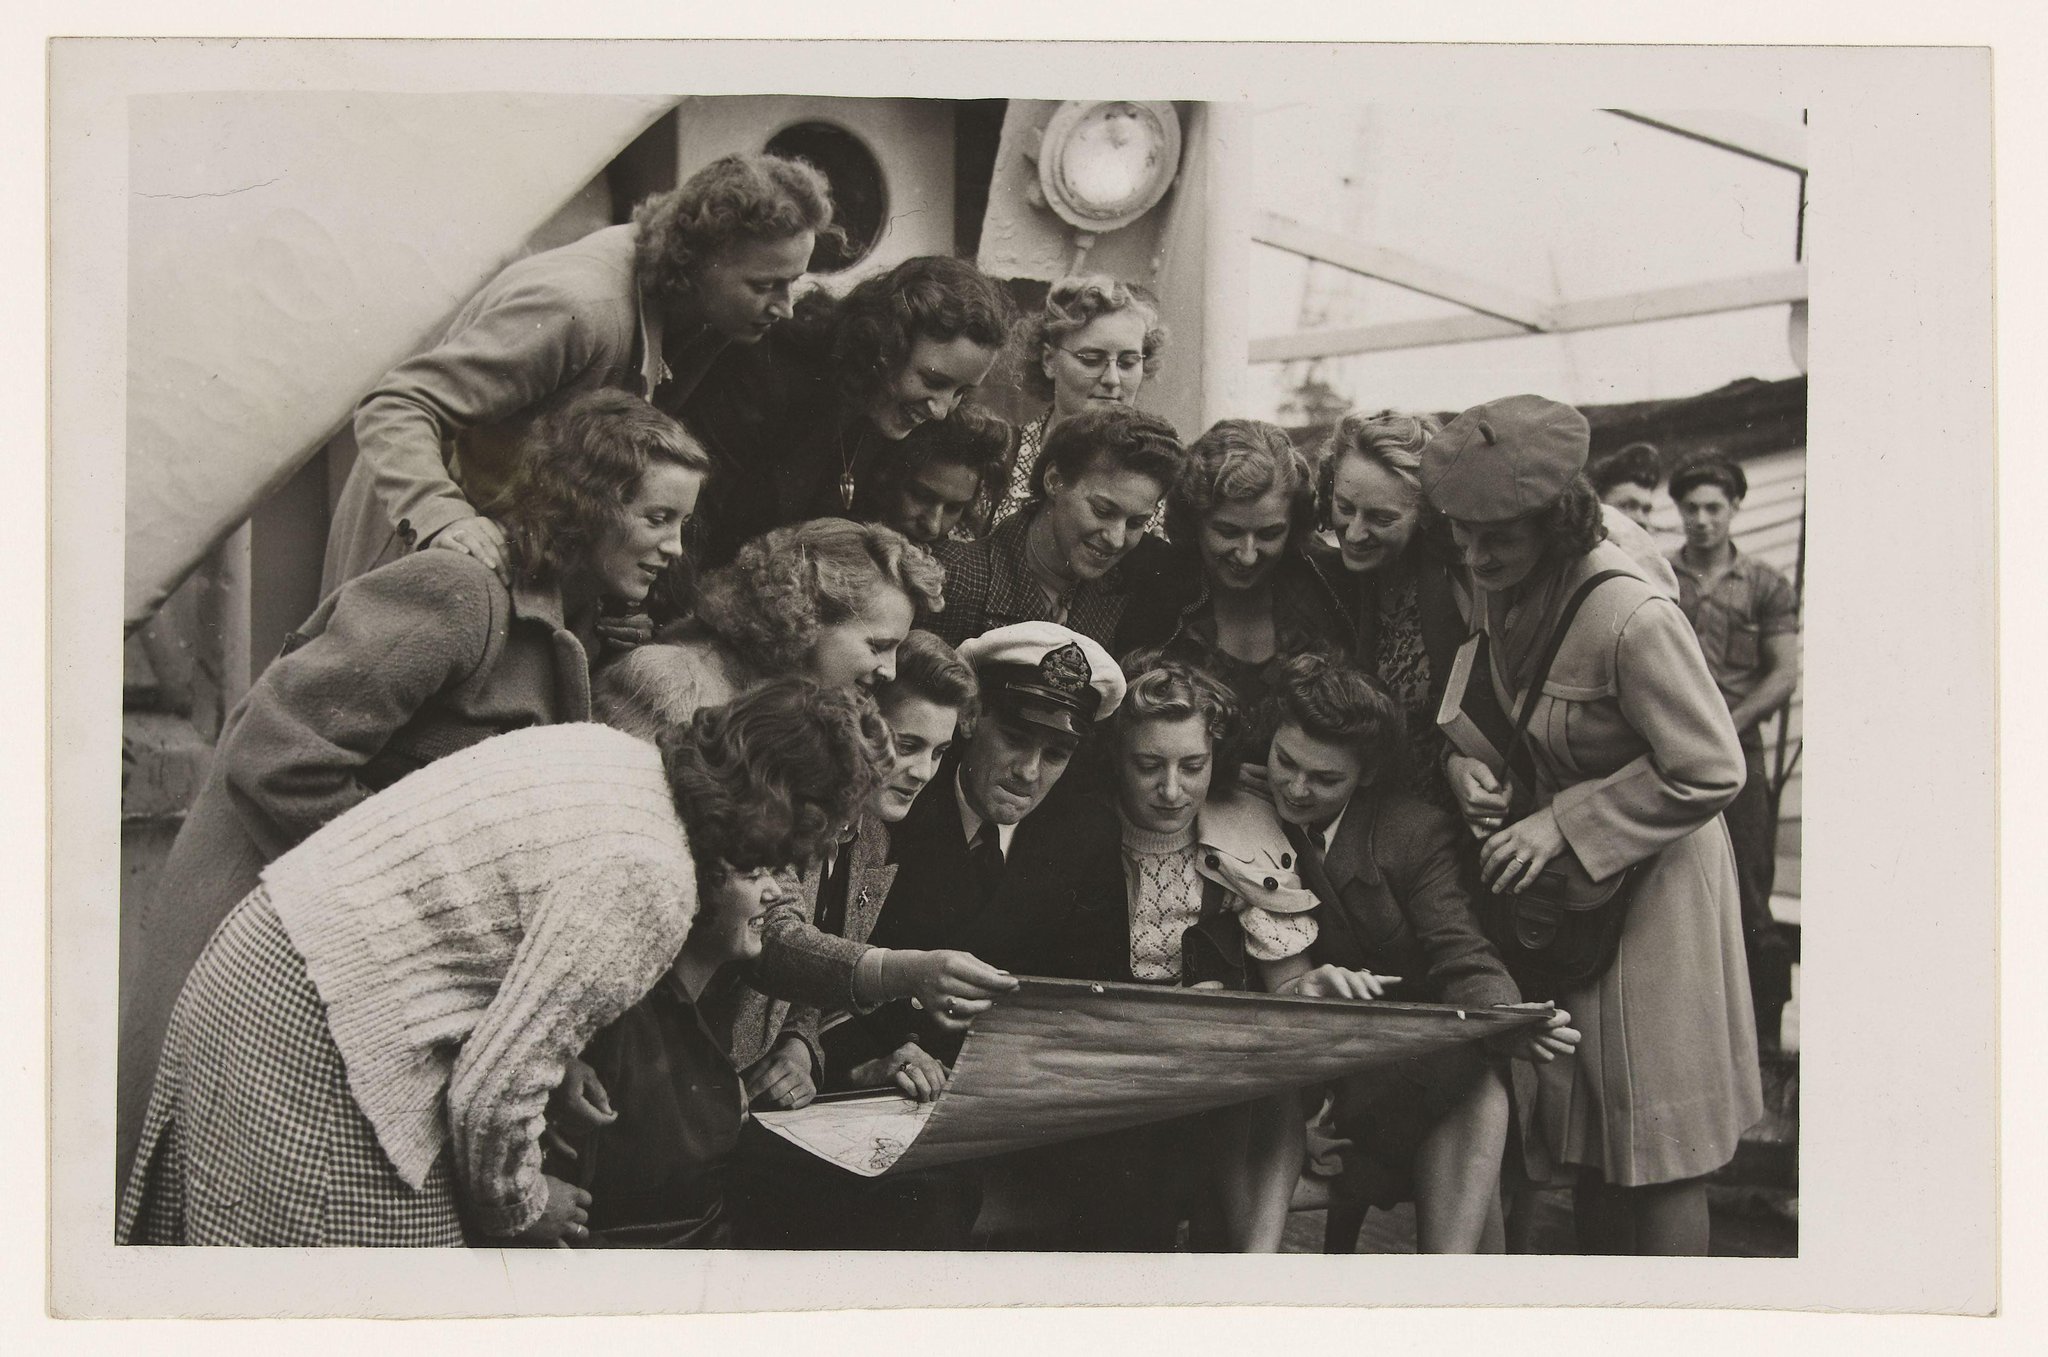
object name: documentary photograph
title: Canadese bruiden vertrekken naar Canada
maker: van t hof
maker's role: fotograaf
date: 1946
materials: photographic support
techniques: photography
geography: rotterdam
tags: canada, rotterdam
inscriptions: number: ‘18929’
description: A. Leblanc, de kapitein van het Canadese schip de S.S. 'Lady Rodney' zit op het dek, omringd door vijftien meisjes, een kaart te lezen. Hij legt de Nederlandse meisjes, die onlangs met Candese militairen in het huwelijk zijn getreden, de te volgen vaarroute naar Canada uit.